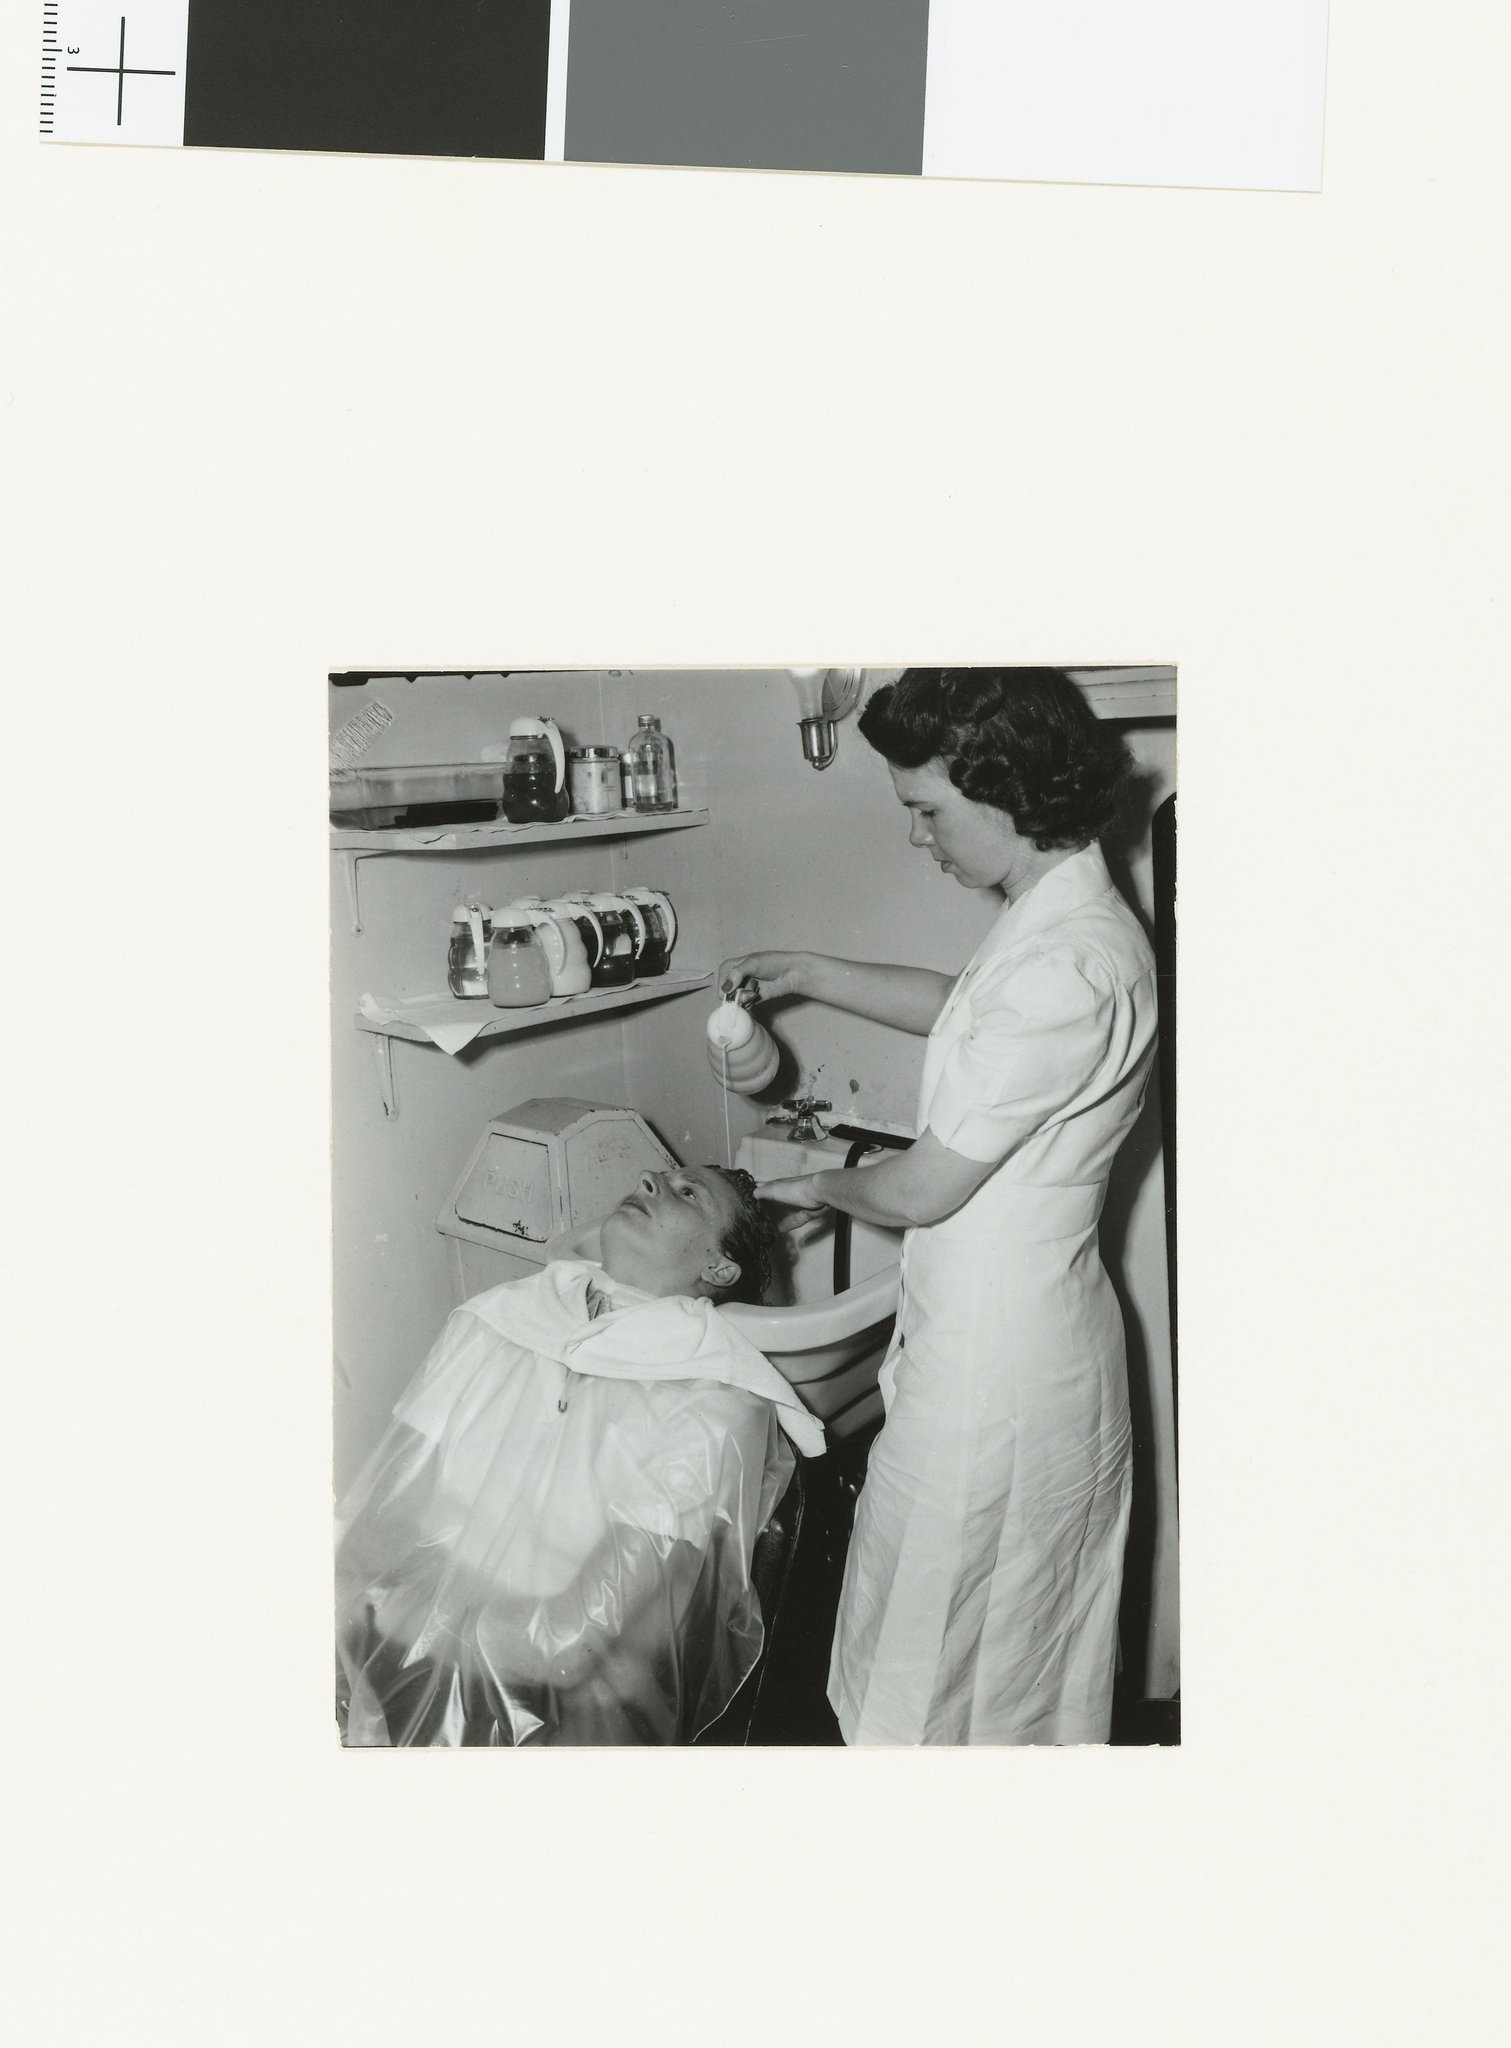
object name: documentary photograph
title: Fanny in Amerika. Ster der Olympische Spelen in New York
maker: Anonymous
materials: photographic support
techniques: photography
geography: hollywood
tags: ons vrije nederland, baarn, hoofddorp, atleet, fanny blankers-koen, hollywood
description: Fanny Blankers-Koen ondergaat een schoonheidsbehandeling in 'House of Westmore', een schoonheidssalon in Hollywood. Allereerst worden haar haren door een schoonheidsspecialiste gewassen. De serie 'Fanny in Amerika' bevat zes foto's.